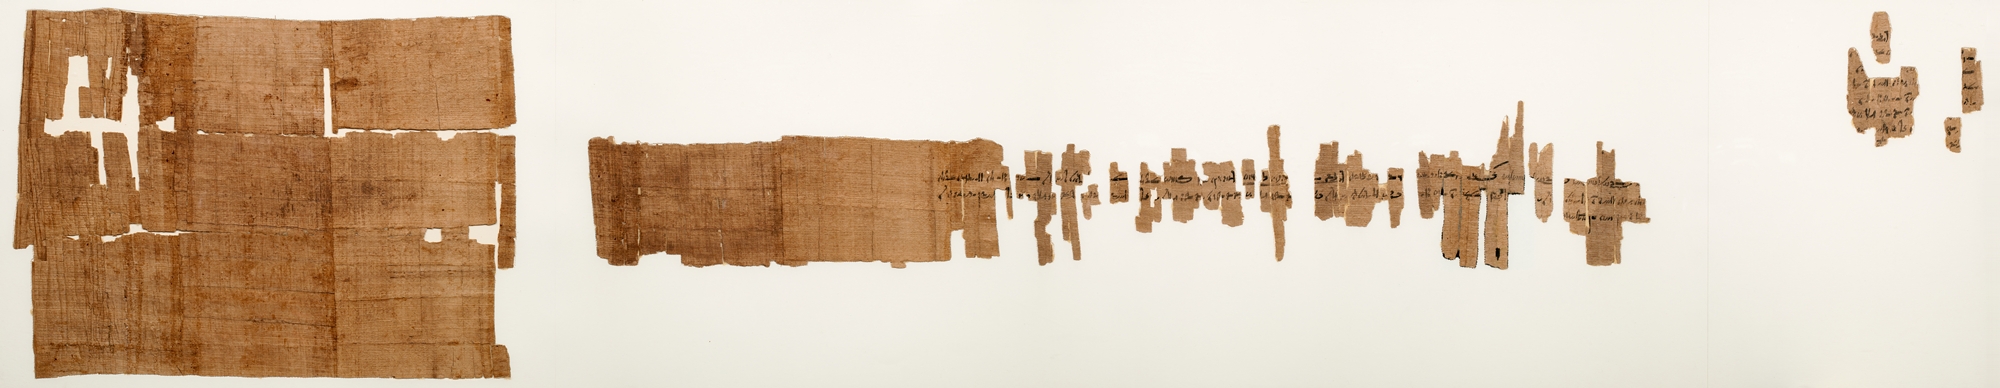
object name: papyrus, marriage contract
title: Marriage Contract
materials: ink, papyrus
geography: western desert; kharga oasis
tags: documents,demotic